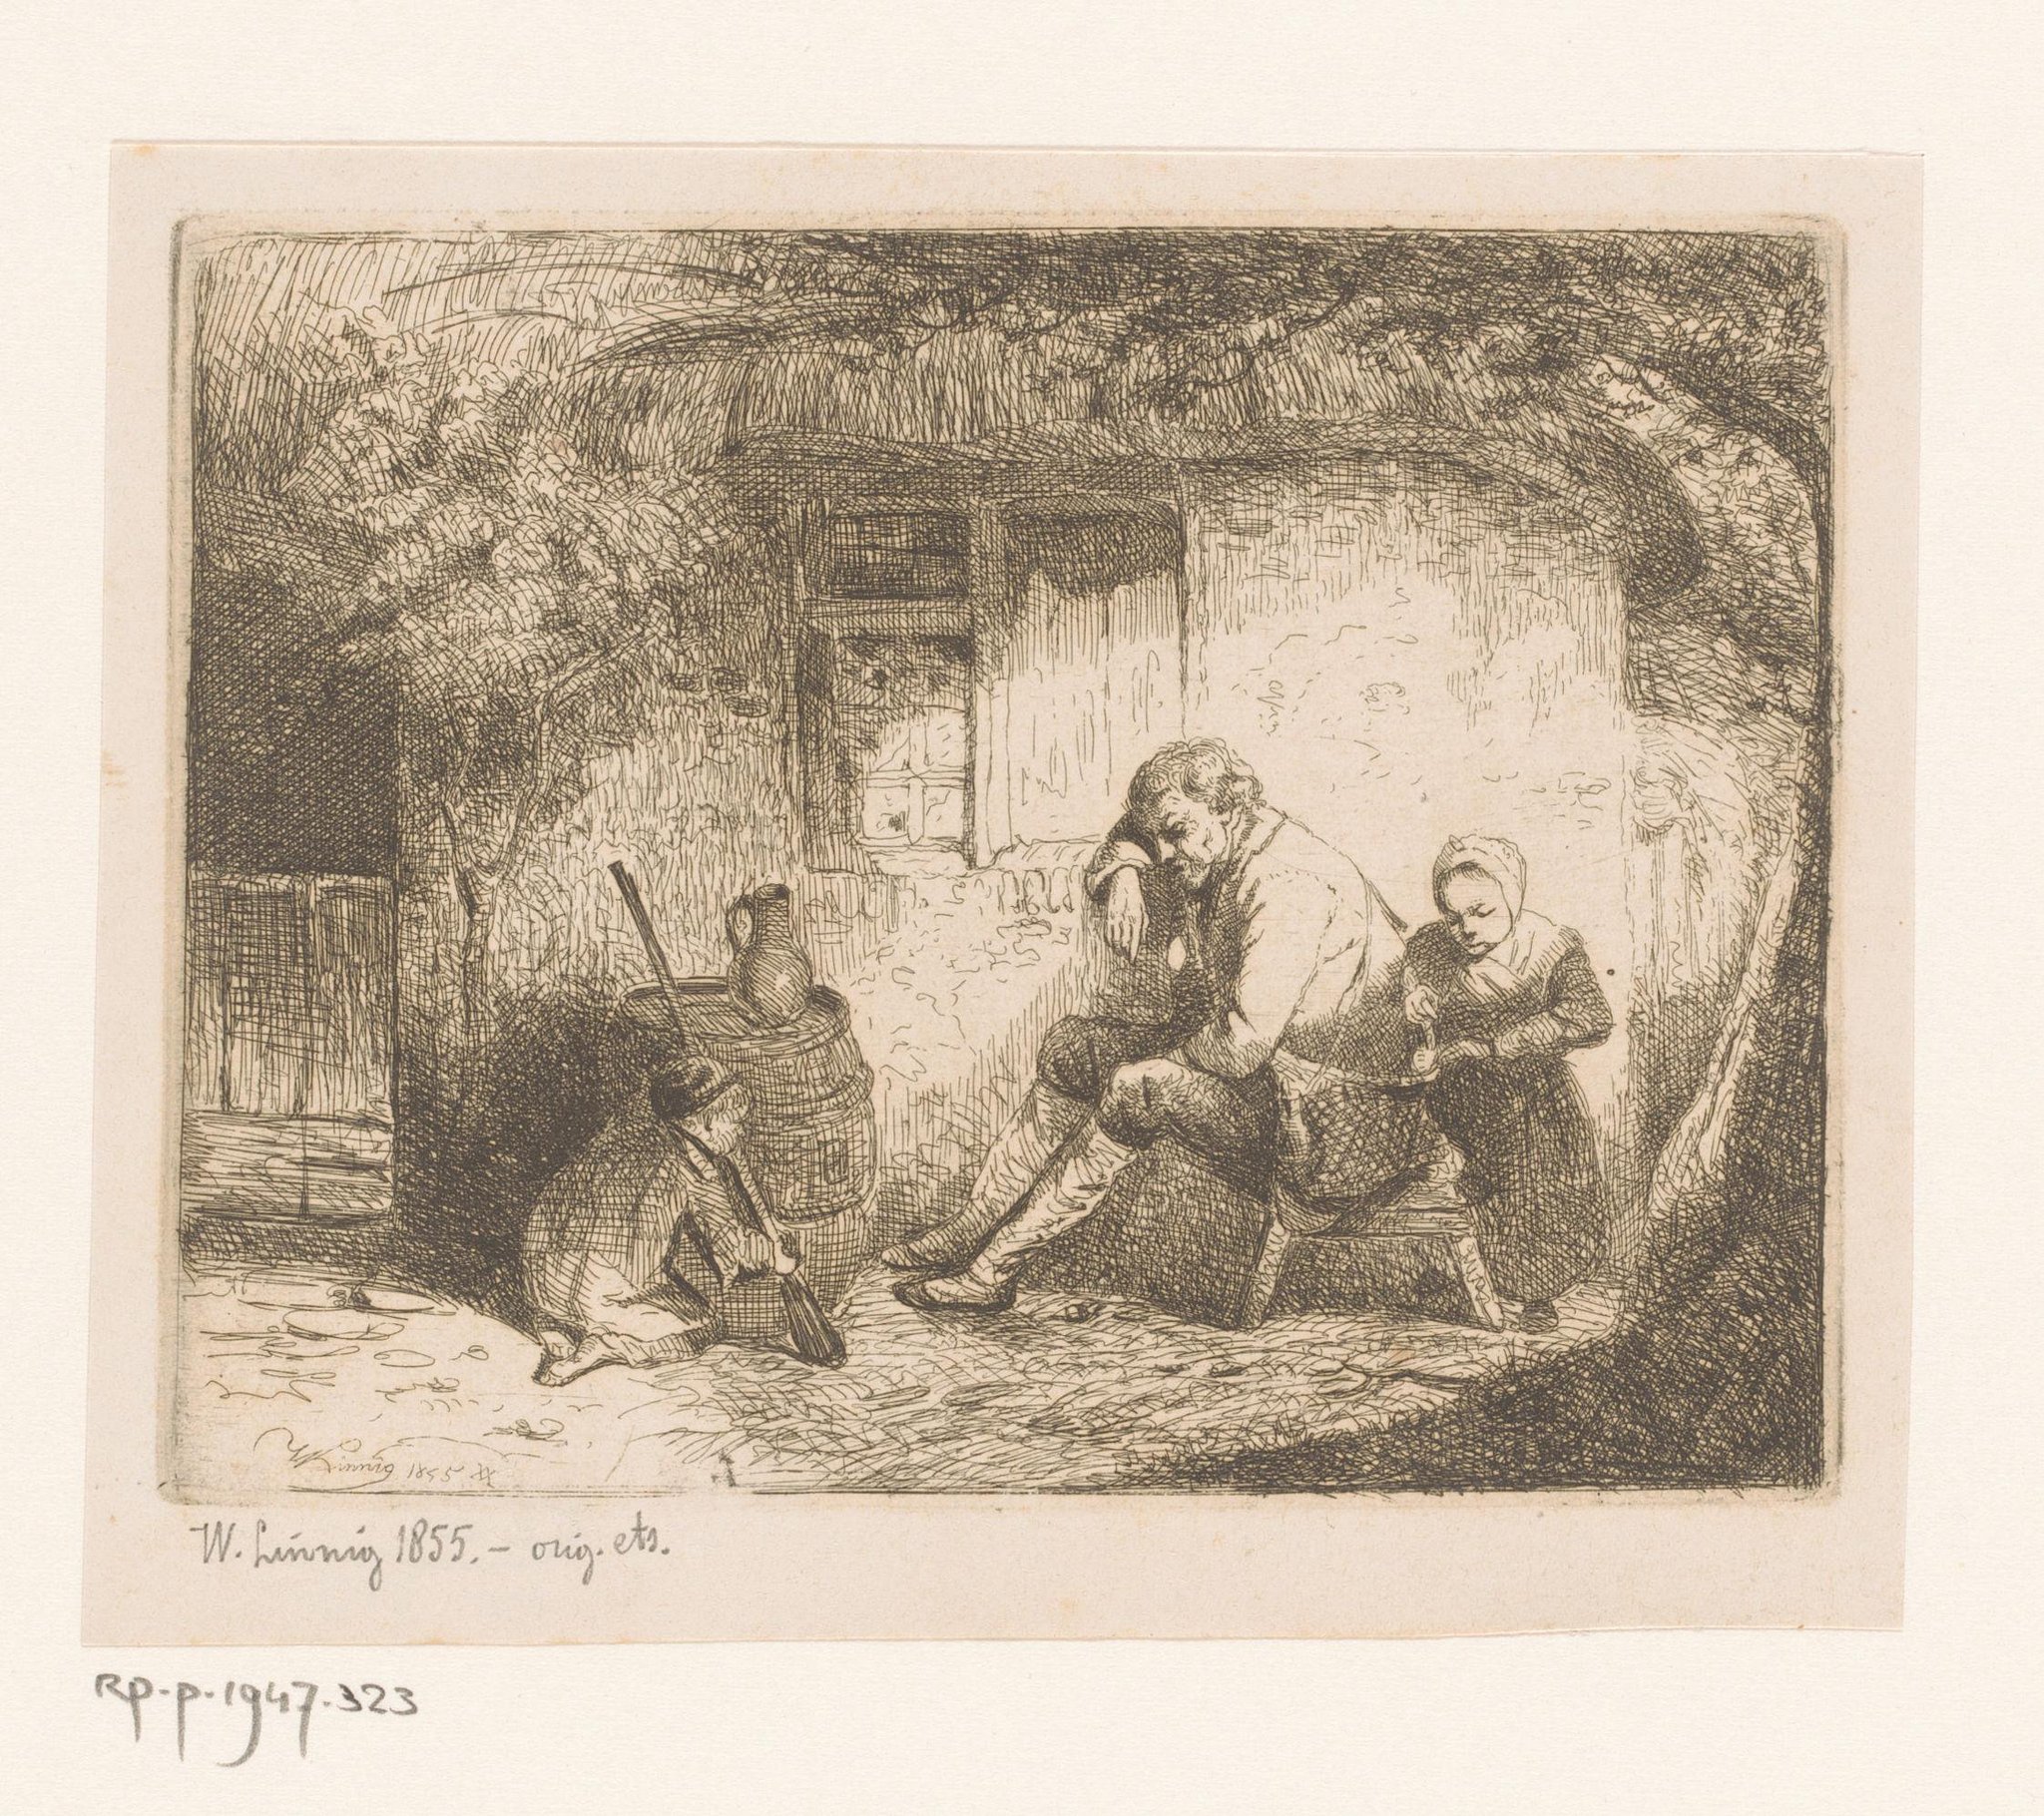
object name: print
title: Jager met twee kinderen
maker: willem linnig (i)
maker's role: print maker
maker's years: 1819-1885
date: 1845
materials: paper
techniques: etching, intaglio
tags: hunter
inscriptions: collector's mark: Lugt 2228